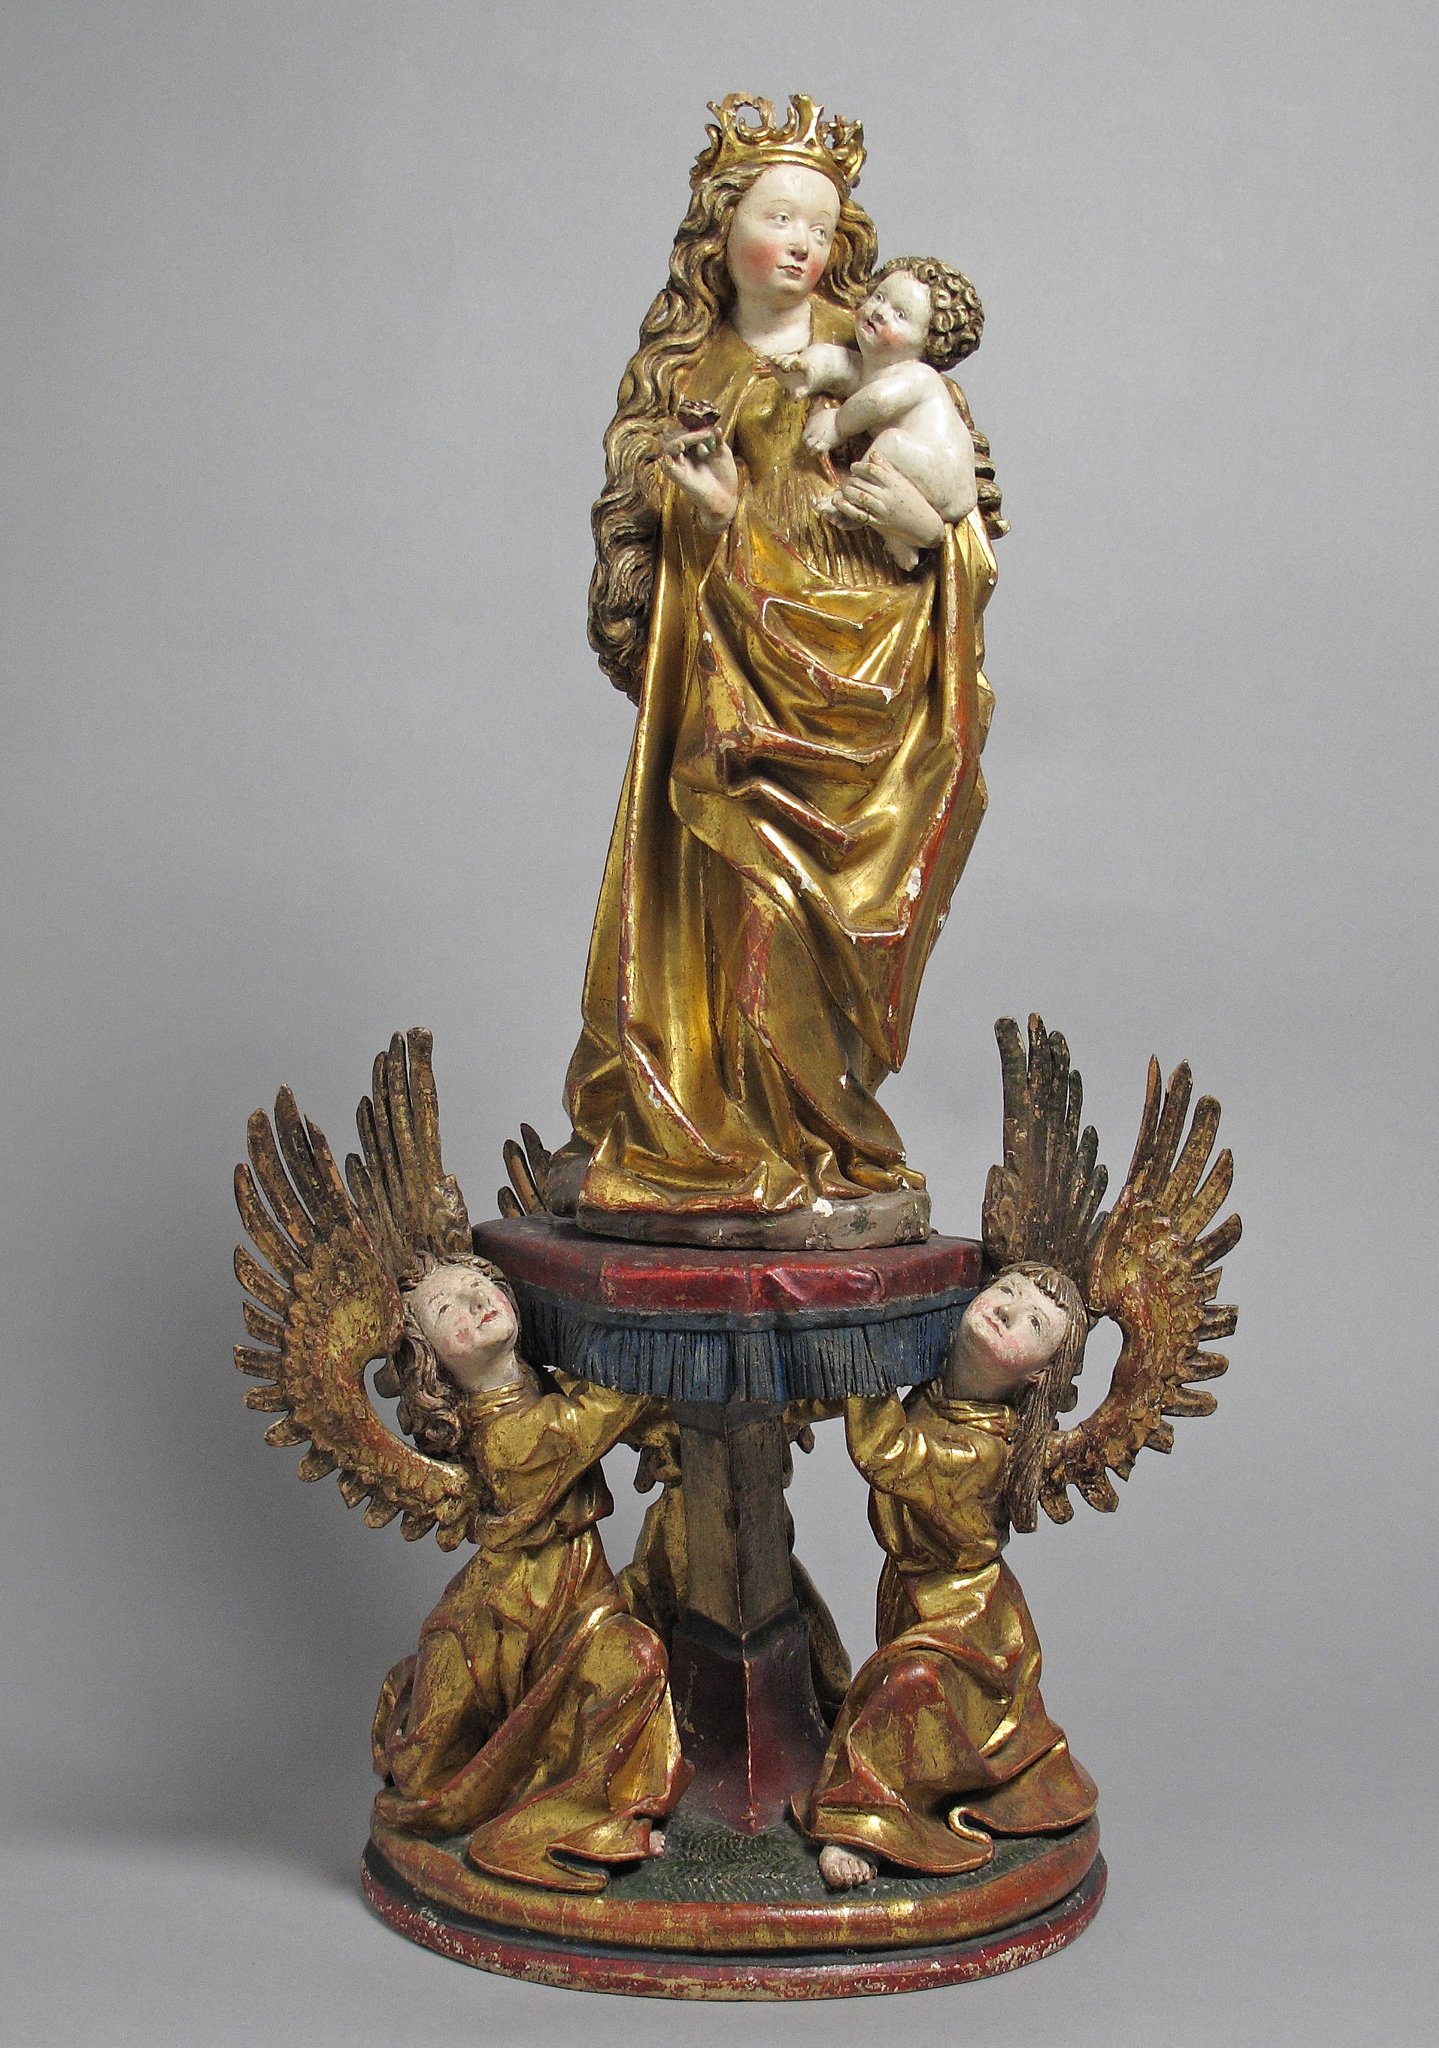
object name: statuette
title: Virgin and Child Supported by Angels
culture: german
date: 1510-1520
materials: paint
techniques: gilding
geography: germany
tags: angels,madonna and child